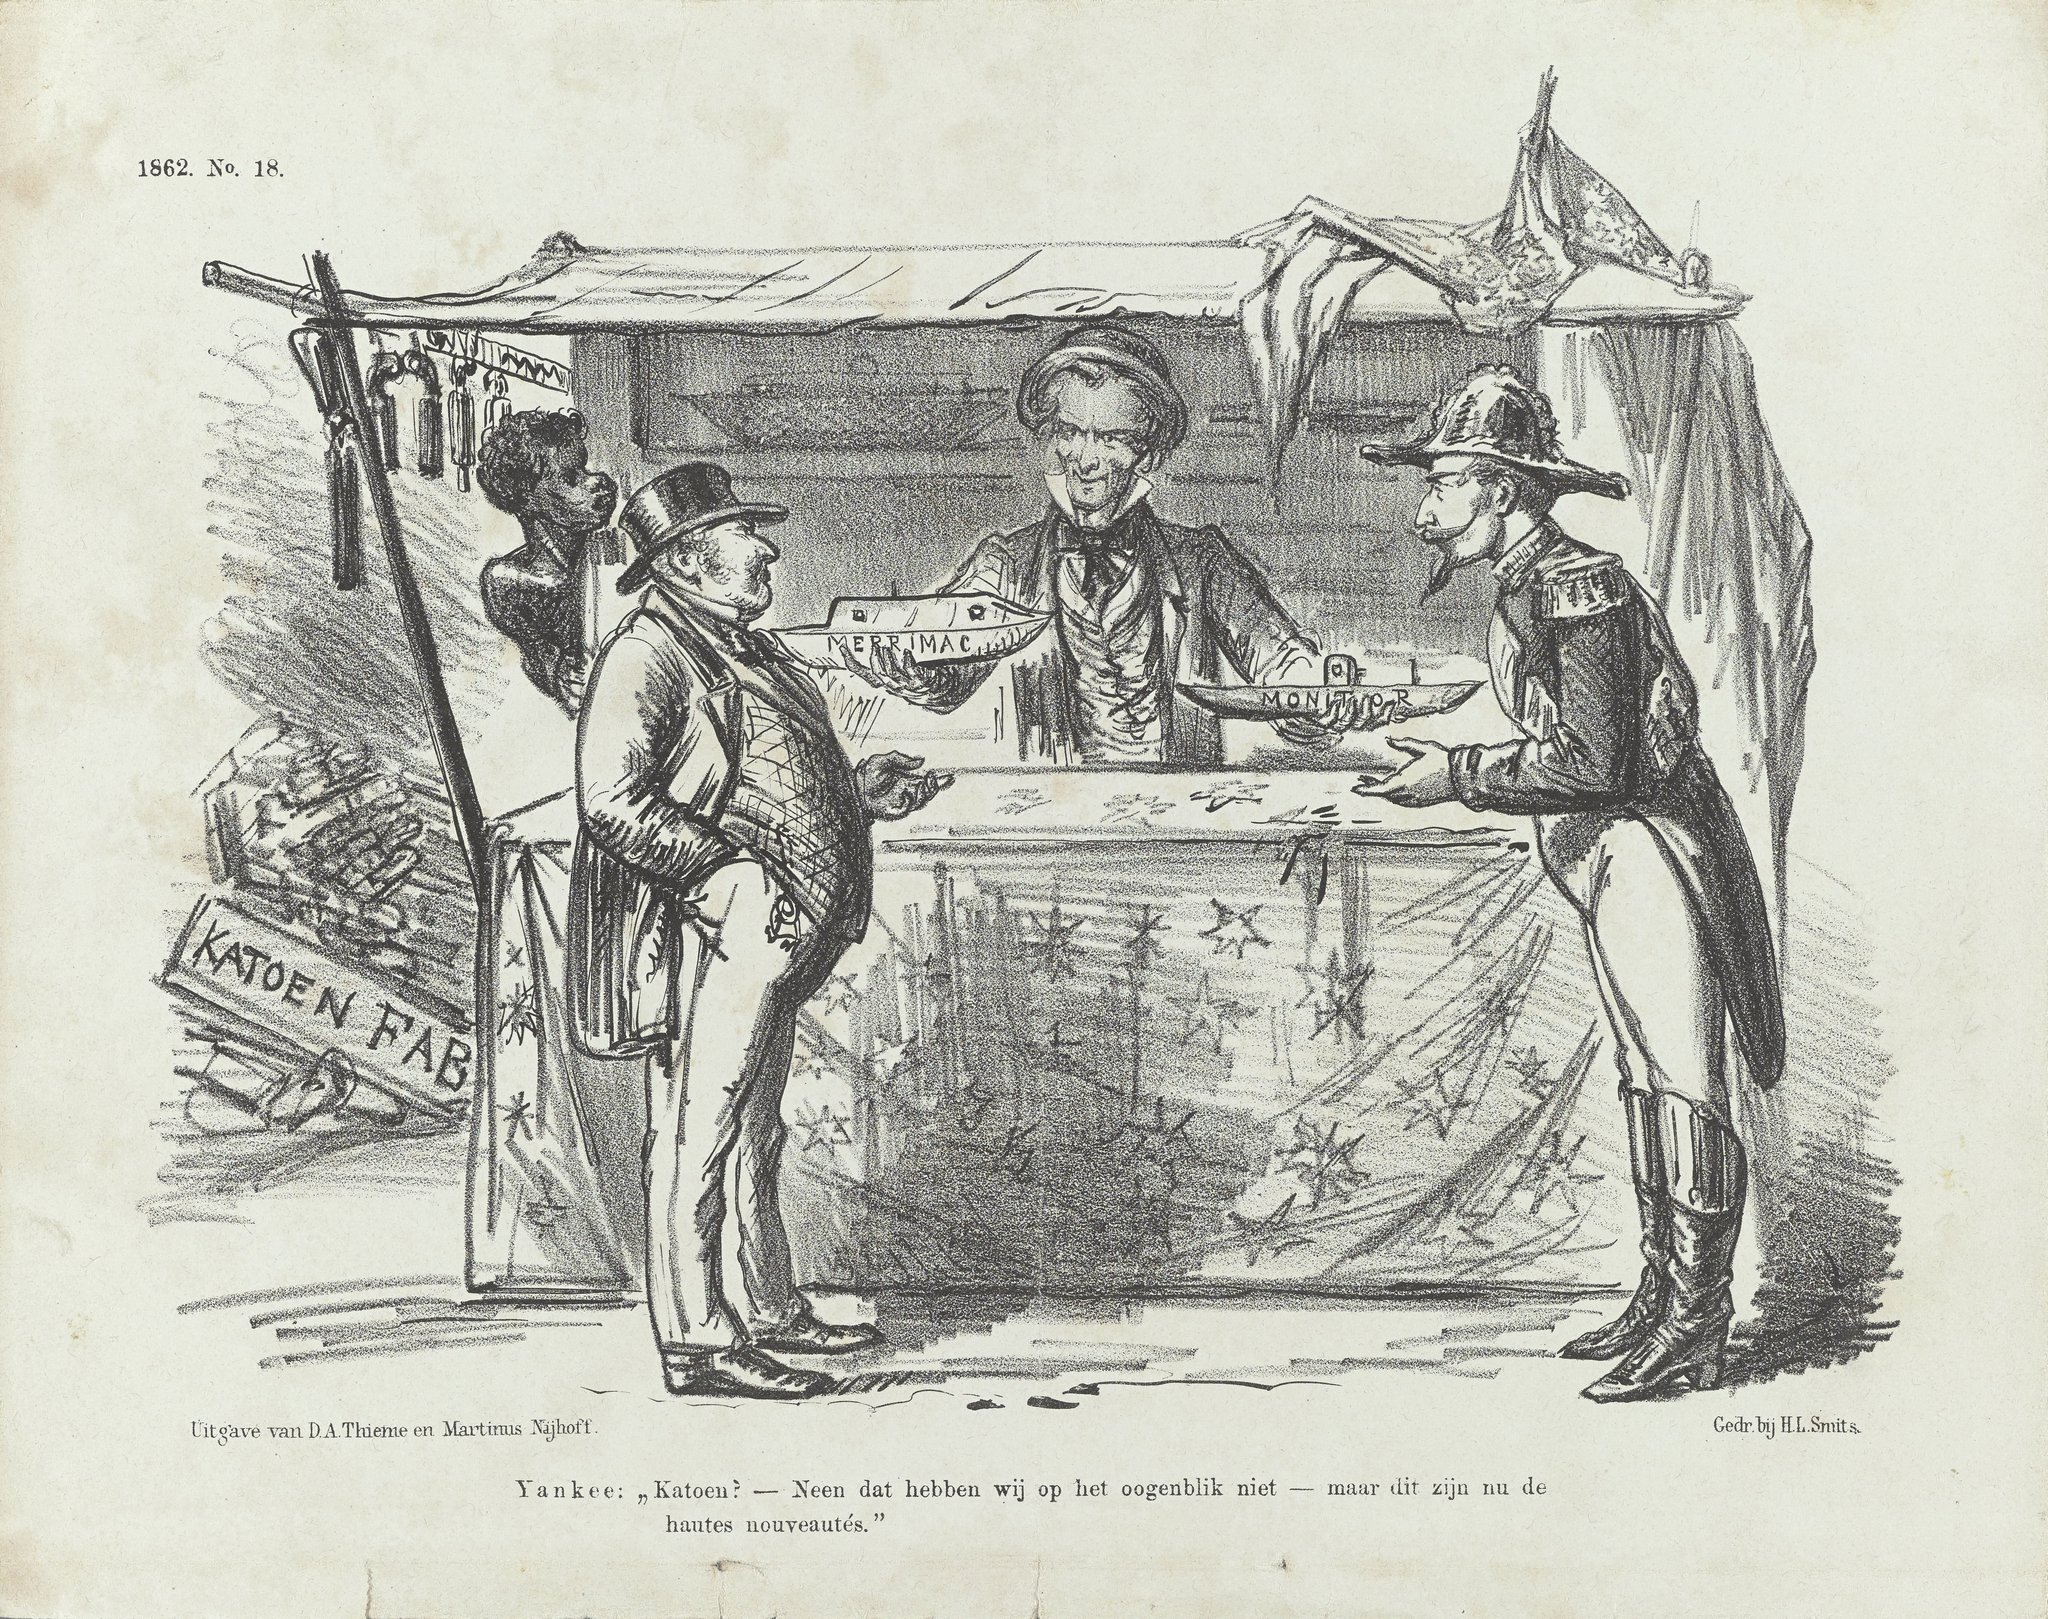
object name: print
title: Spotprent op de nieuwe Amerikaanse oorlogsschepen, 1862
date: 1862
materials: paper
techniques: lithograph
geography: netherlands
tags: paris, london, napoleon iii (keizer der fransen), navy (+ motor ships), personifications of countries, nations, states, districts, etc., stall, booth (~ market), slavery; serfs and enslaved persons, united states of america, france, england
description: Spotprent met John Bull (Engeland) en keizer Napoleon III bij een Amerikaanse kraam waar geen katoen meer verkrijgbaar is maar wel de nieuwe Amerikaanse oorlogsschepen de Merrimac en de Monitor. Een tot slaaf gemaakte man van Afrikaanse oorsprong kijkt om de hoek van de kraam. Naar aanleiding van de rol van deze schepen tijdens de Slag bij Hampton Roads op 9 maart 1862 tijdens de Amerikaanse Burgeroorlog. Plaat verschenen bij het weekblad De Nederlandsche Spectator, nr. 18, 3 mei 1862.